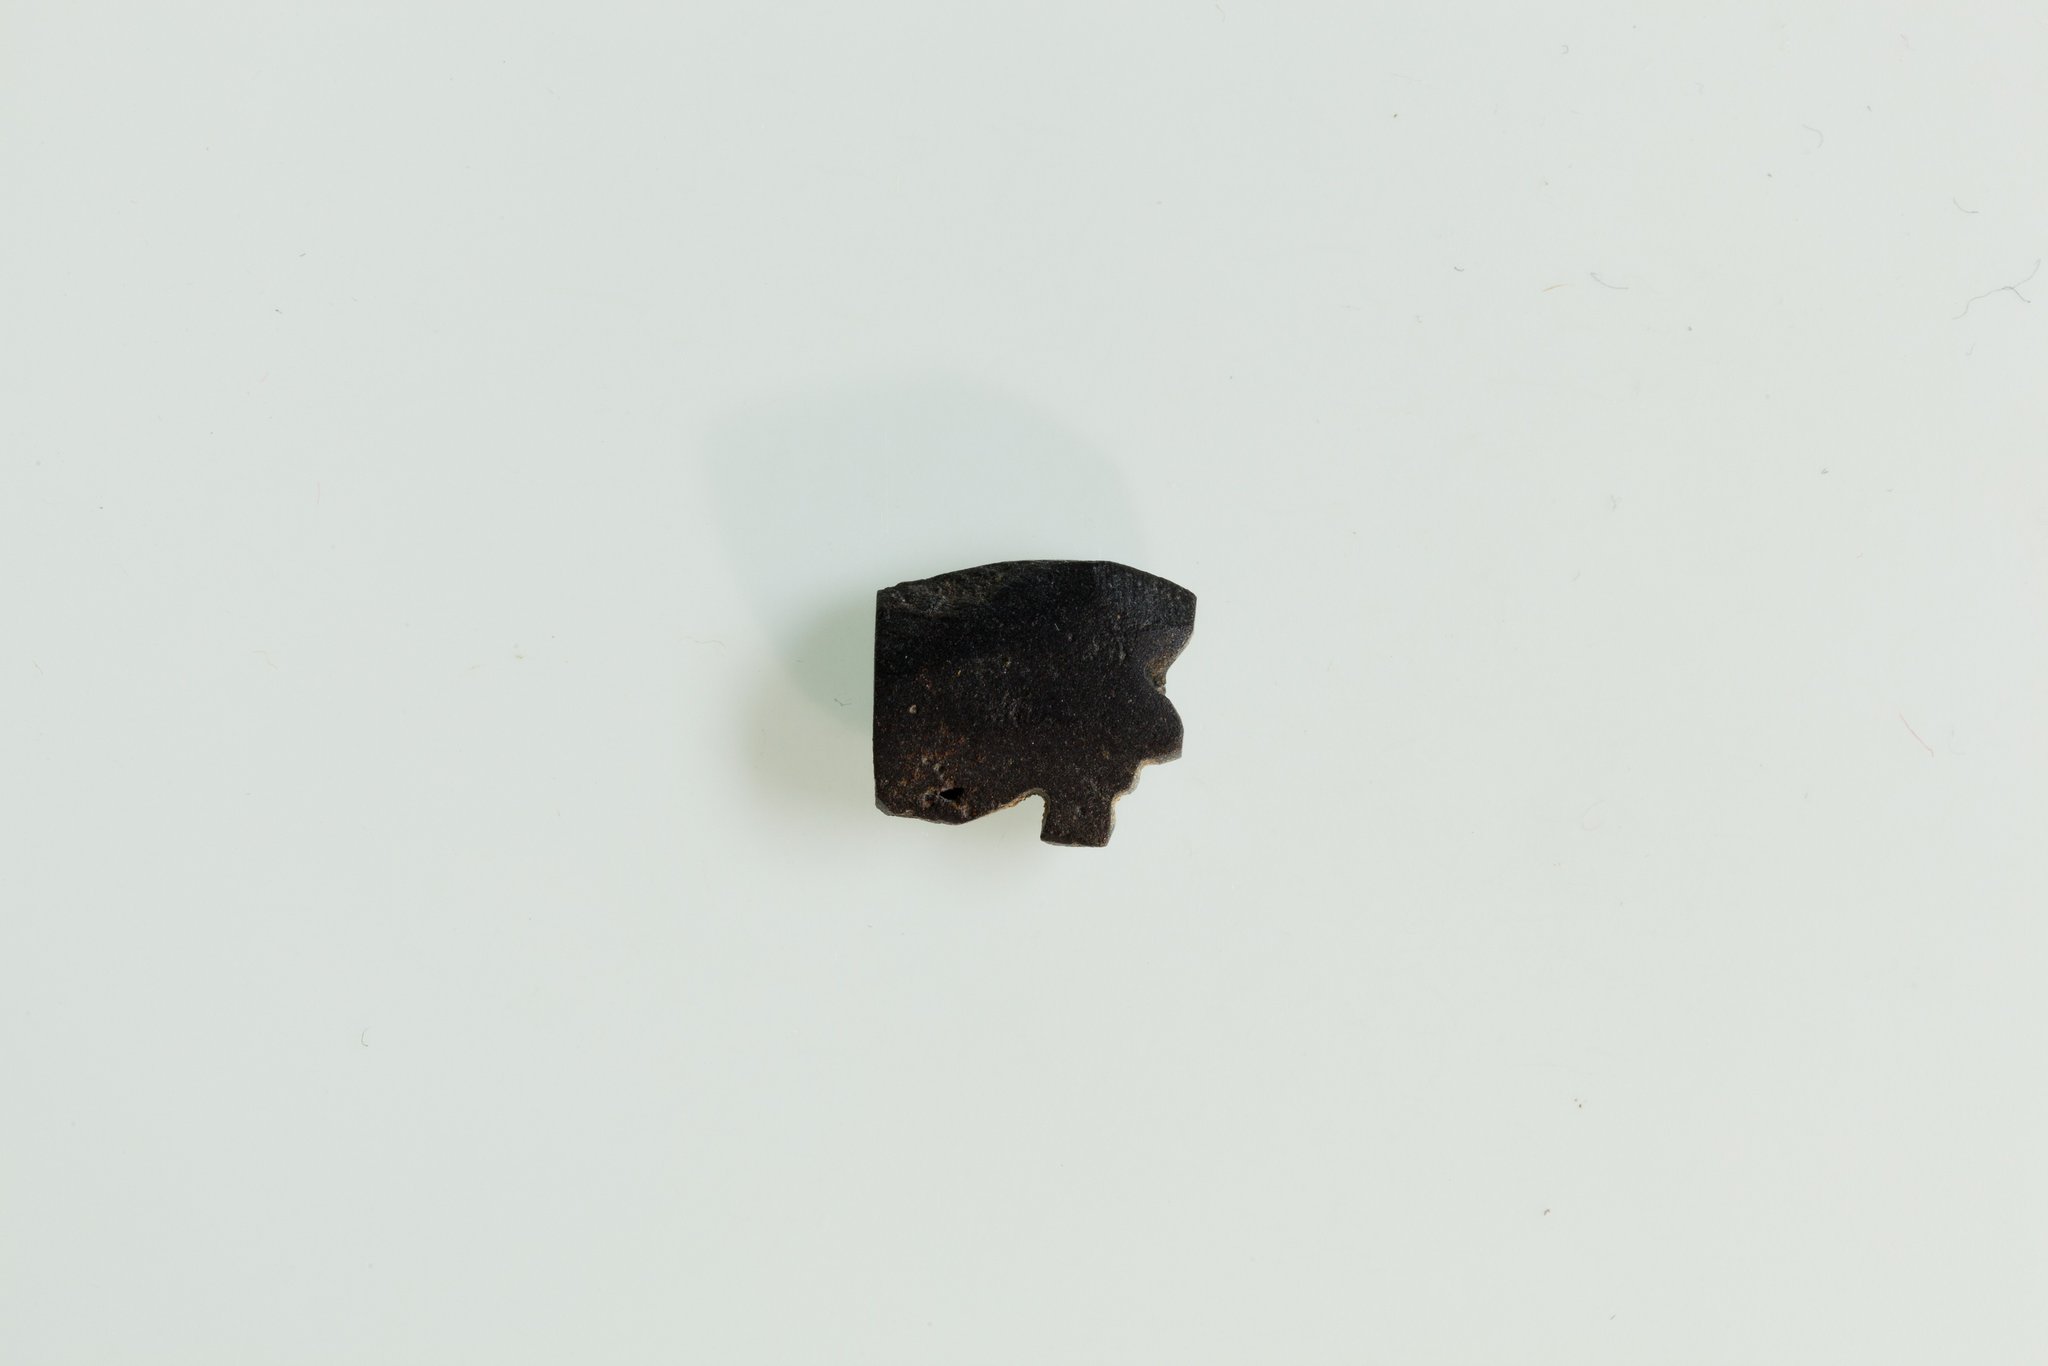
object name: amulet, wedjat eye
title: Wedjat eye from string of amulets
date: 1070-945 BCE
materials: mineral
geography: egypt